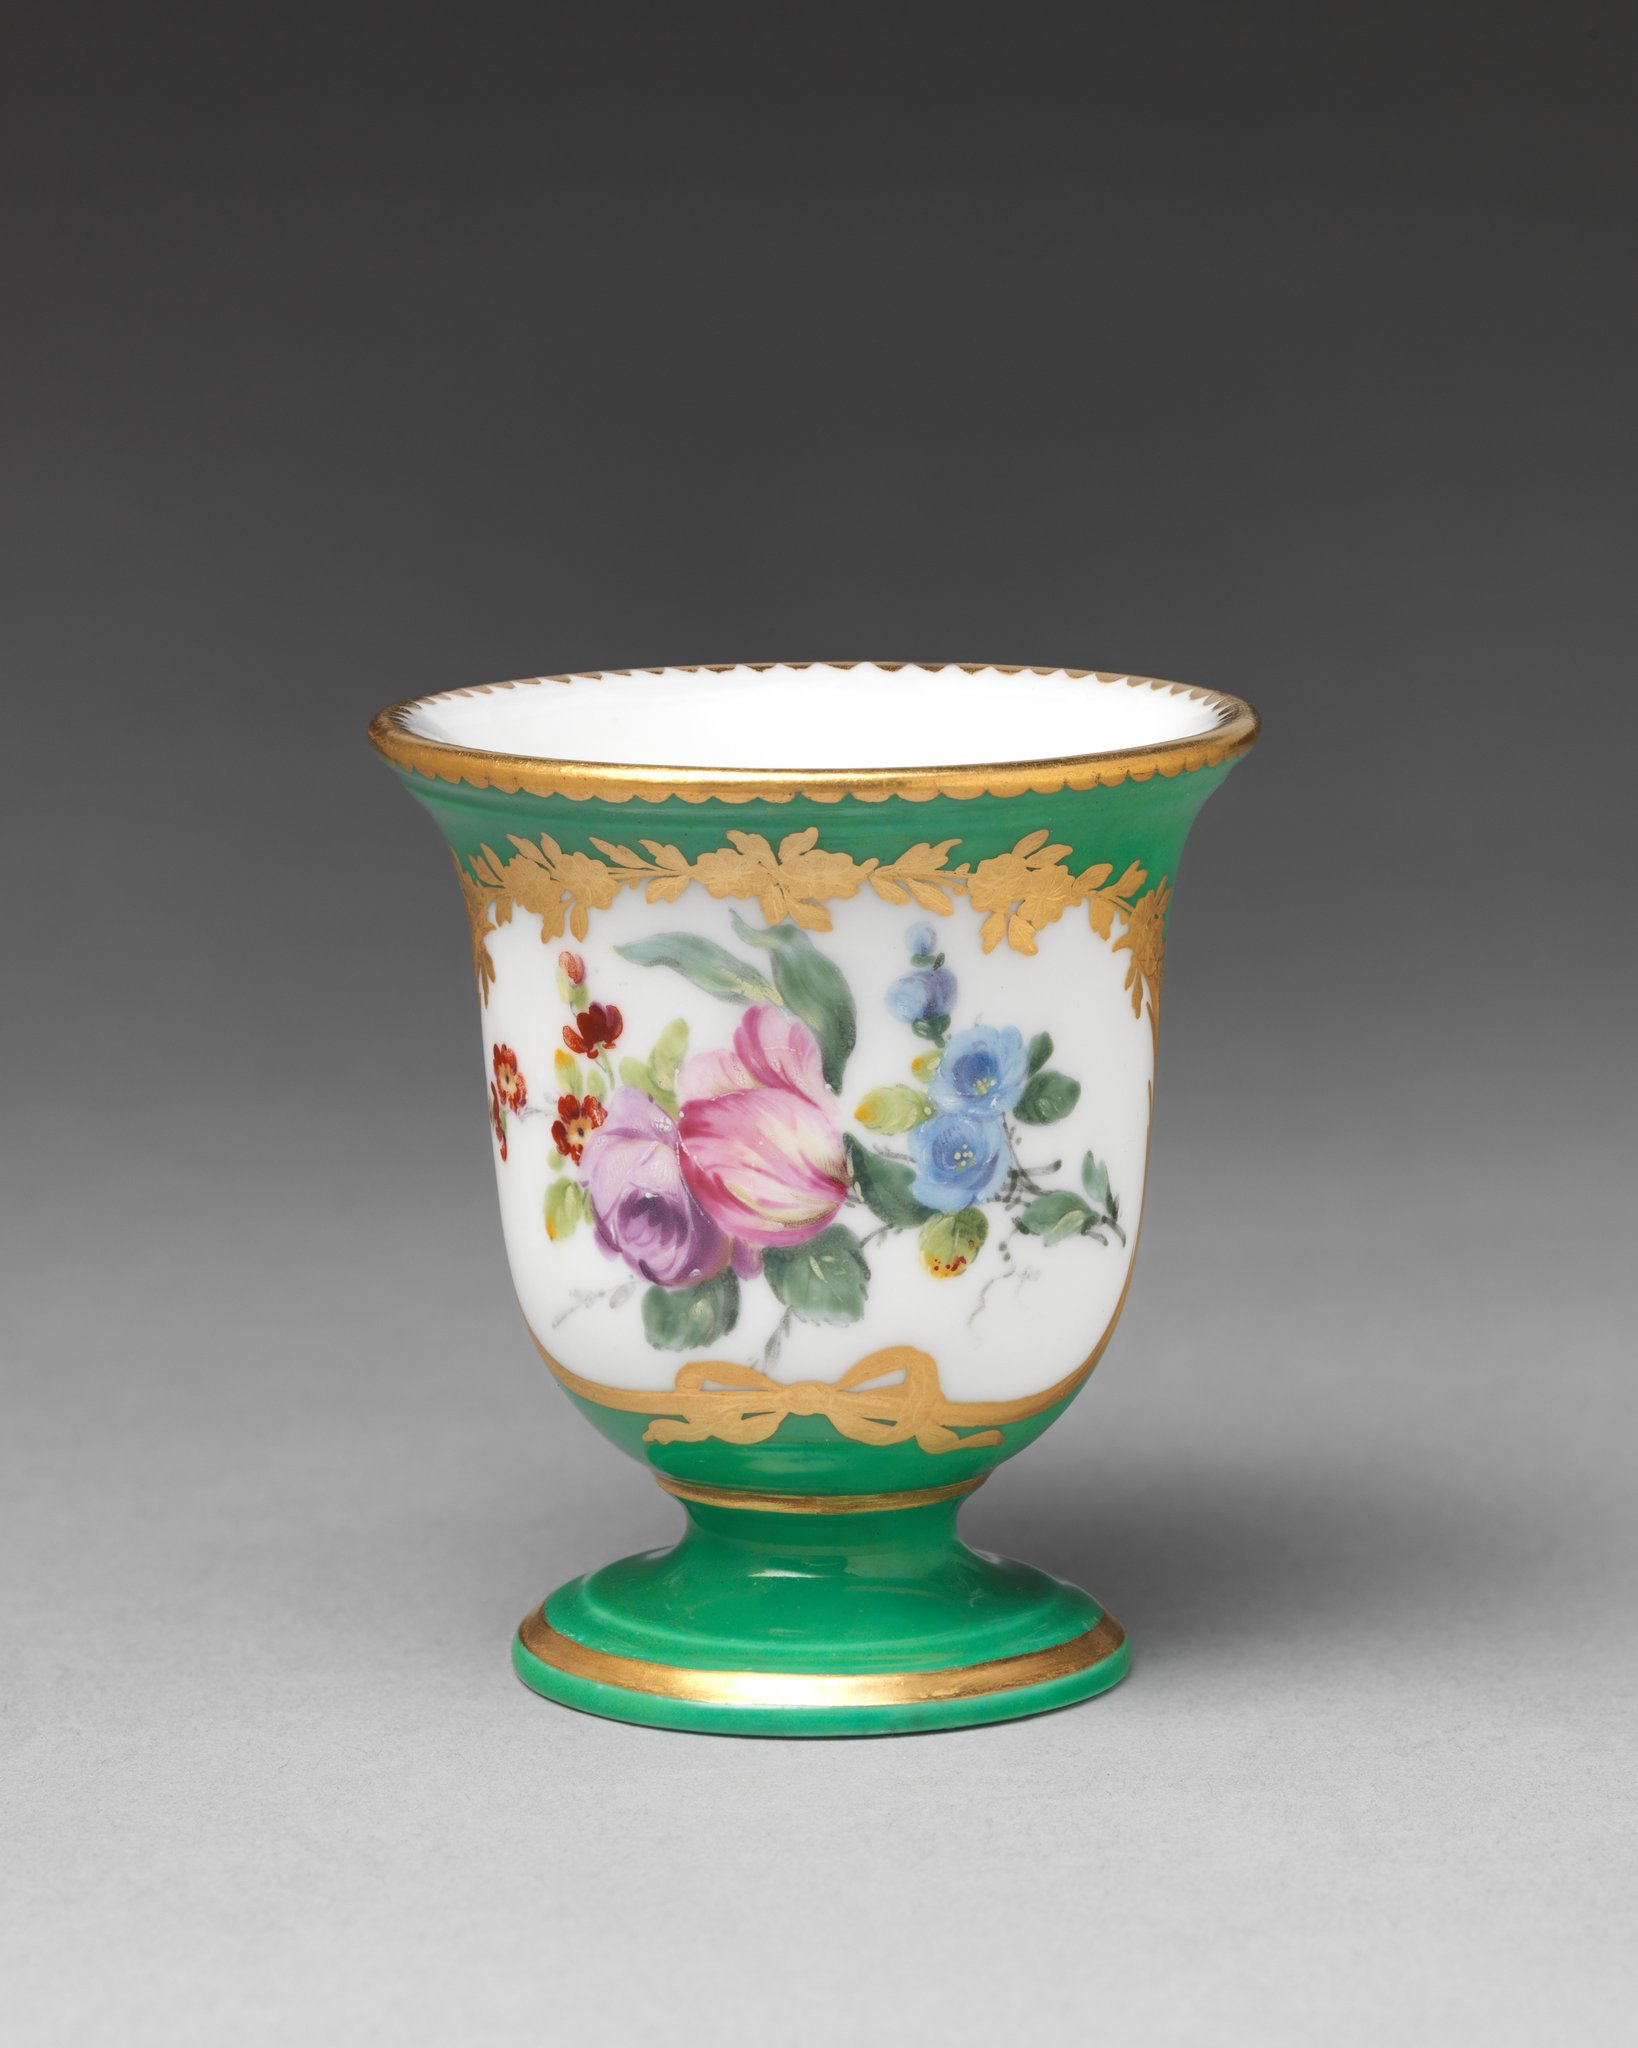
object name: ice cream cup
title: Ice cream cup (tasse à glace) (one of thirty-one) (part of a service)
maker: sèvres manufactory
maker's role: manufactory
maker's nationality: french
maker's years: 1740-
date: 1771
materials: soft paste porcelain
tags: flowers